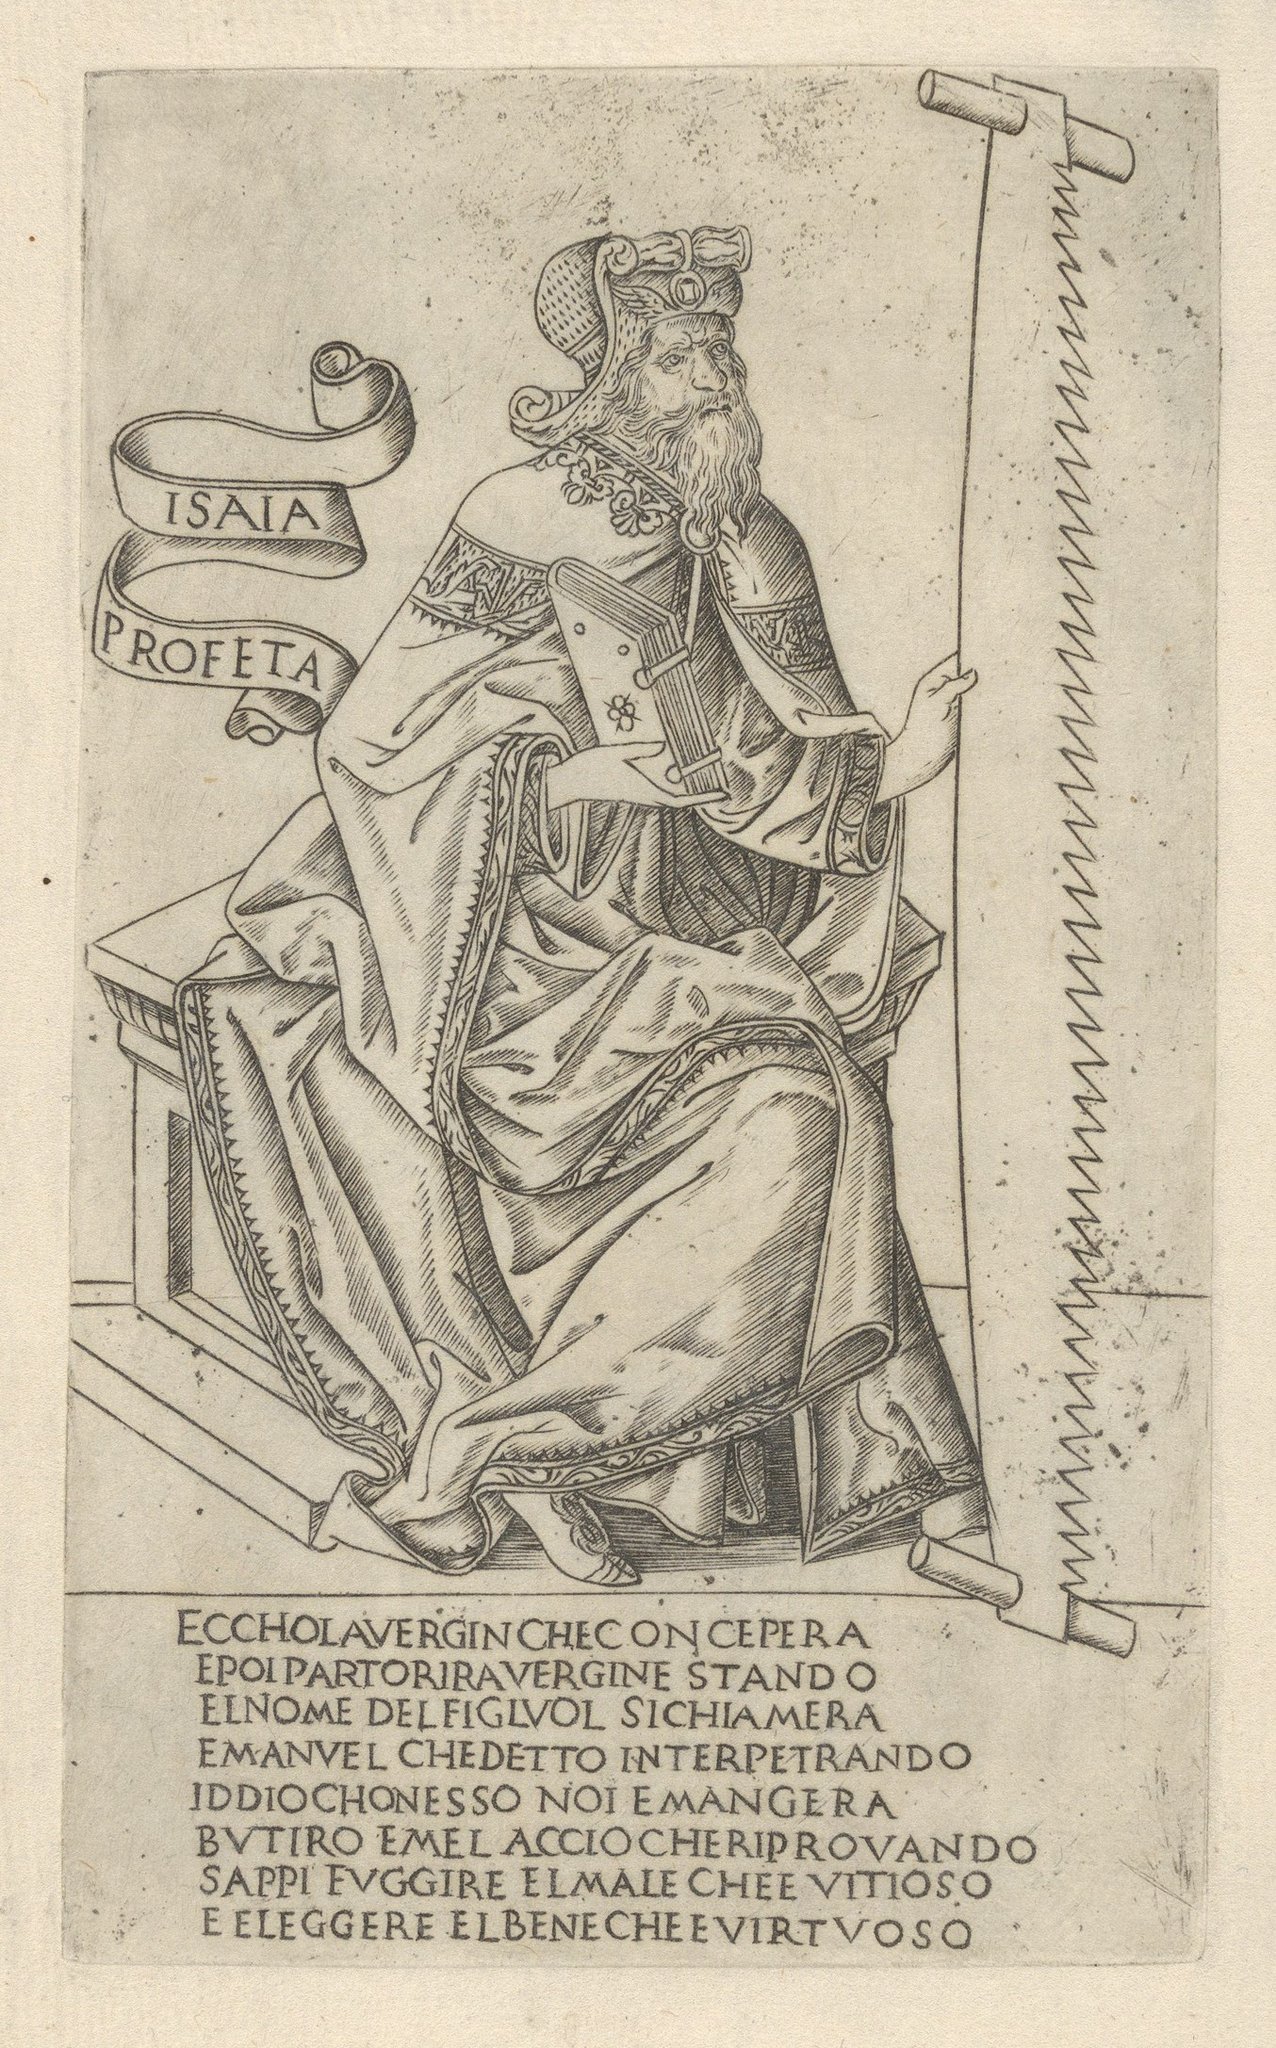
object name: print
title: The Prophet Isaiah, from "Prophets and Sibyls"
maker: francesco rosselli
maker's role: artist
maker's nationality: italian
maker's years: 1448-1527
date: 1480-1490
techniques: engraving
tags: men